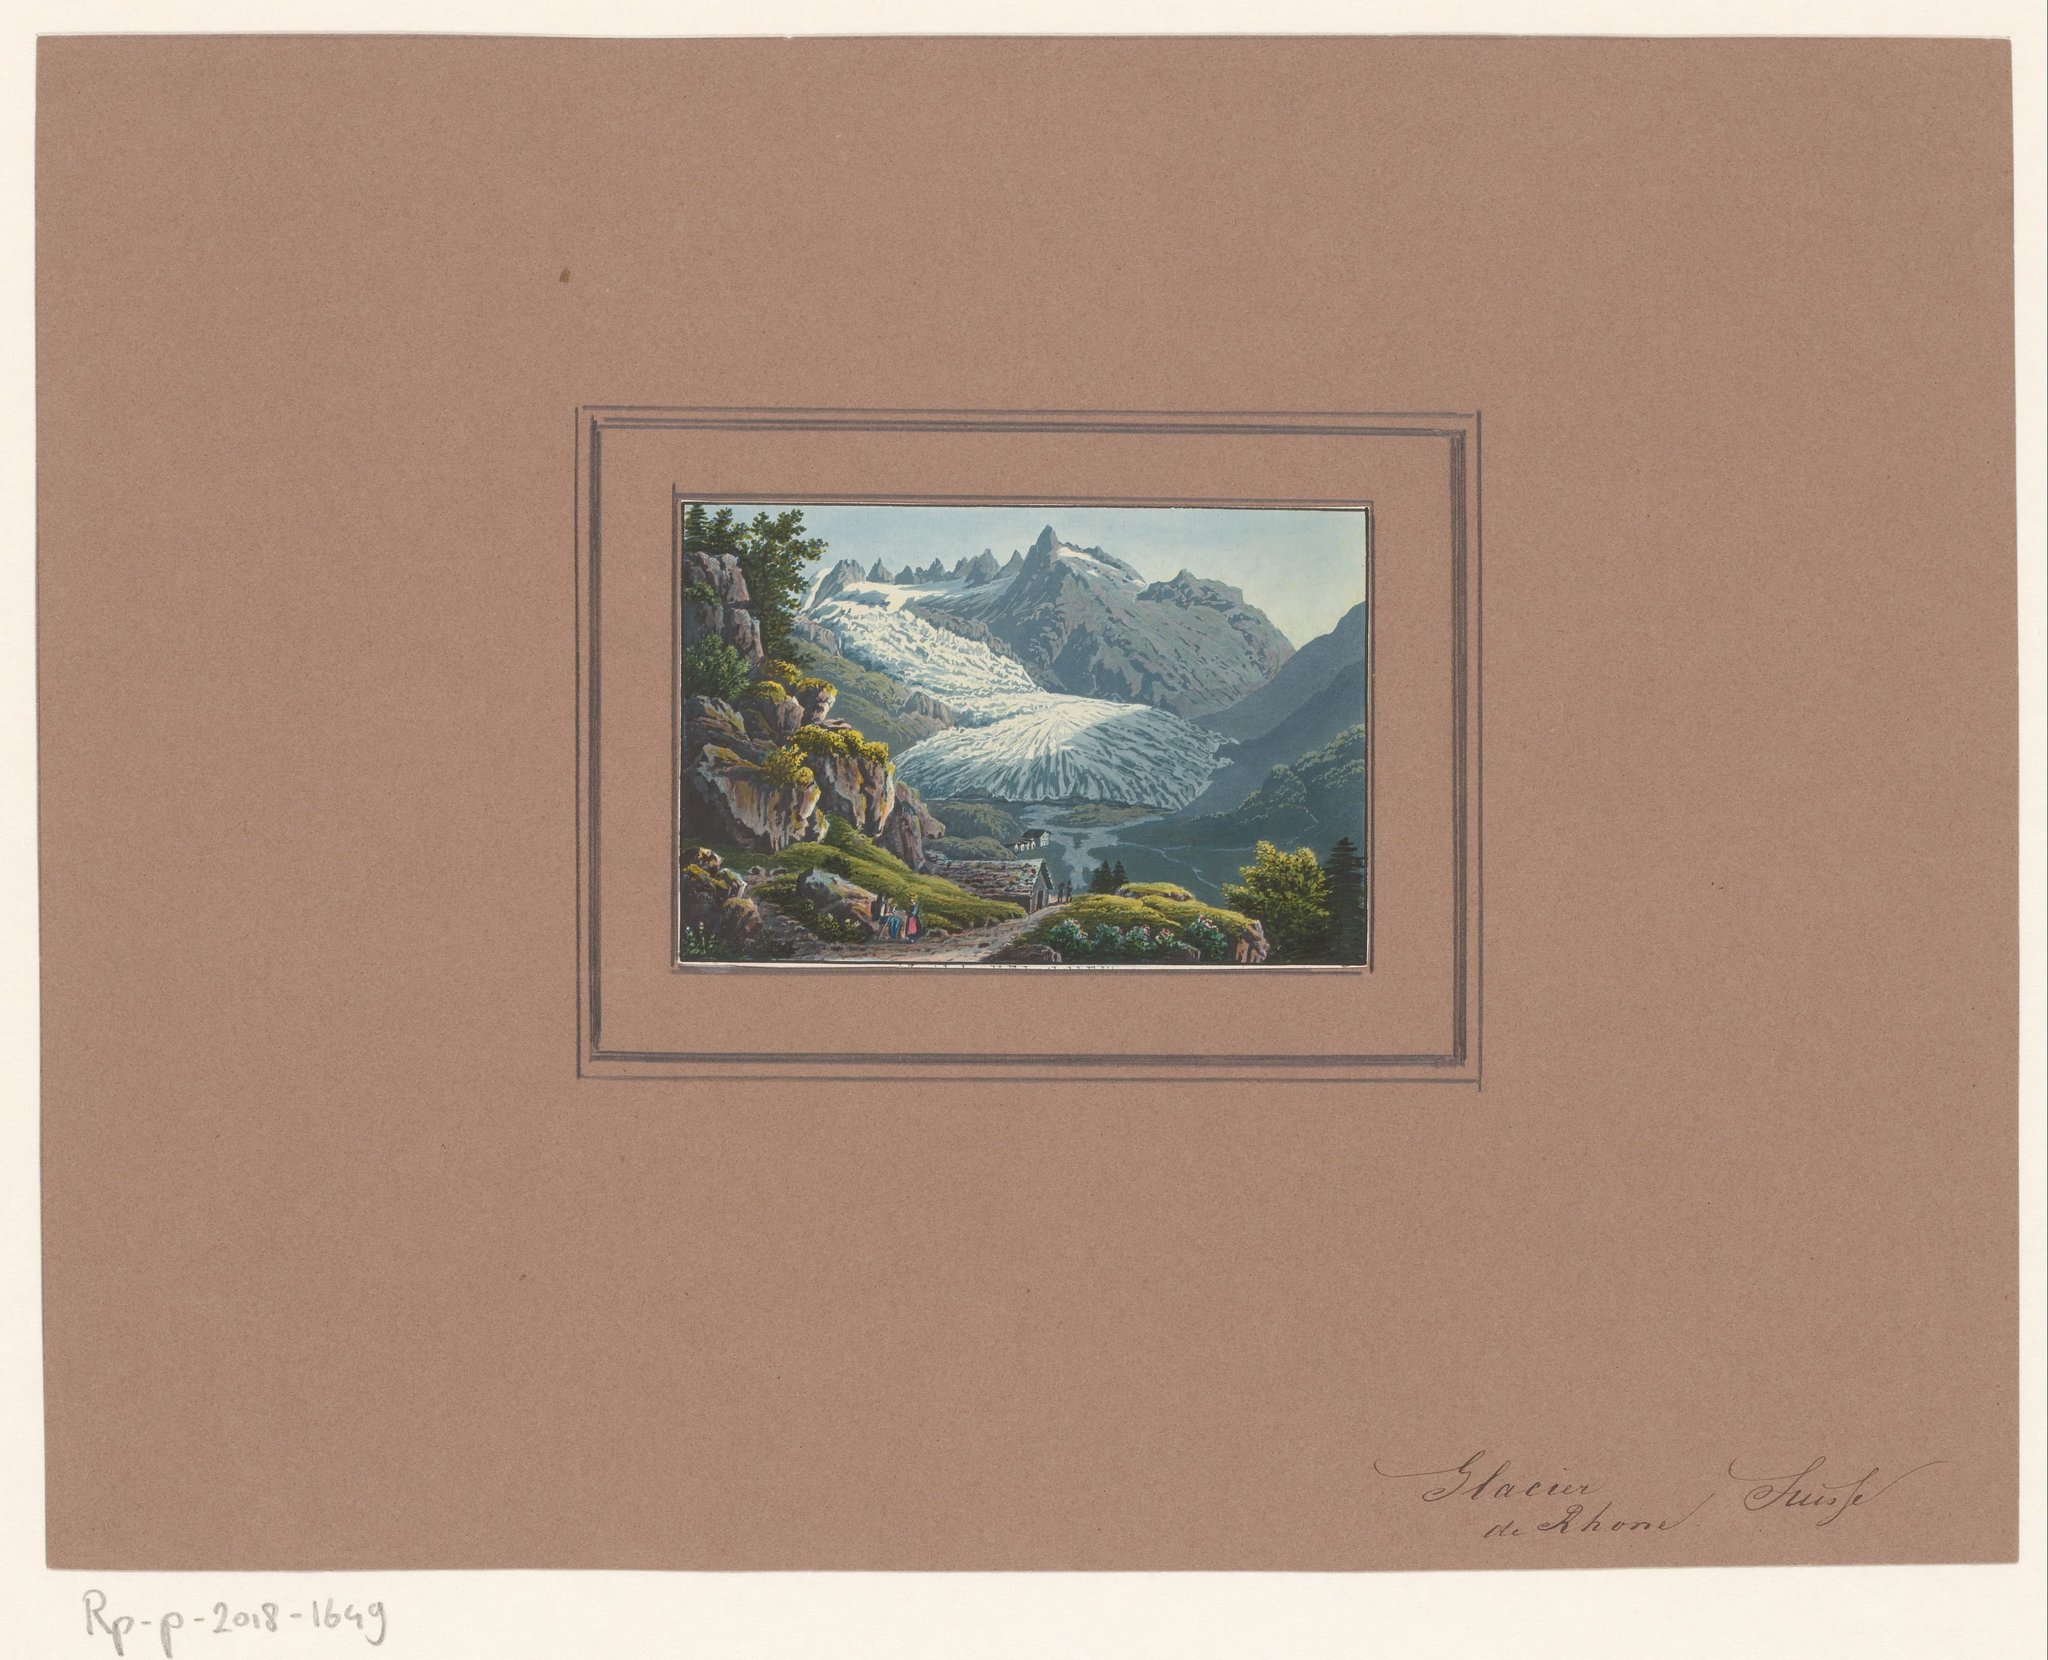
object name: print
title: Glacier de Rhone / Suisse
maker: Anonymous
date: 1800-1899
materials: paper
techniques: lithograph, hand coloring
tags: glacier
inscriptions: collector's mark: Lugt 2228